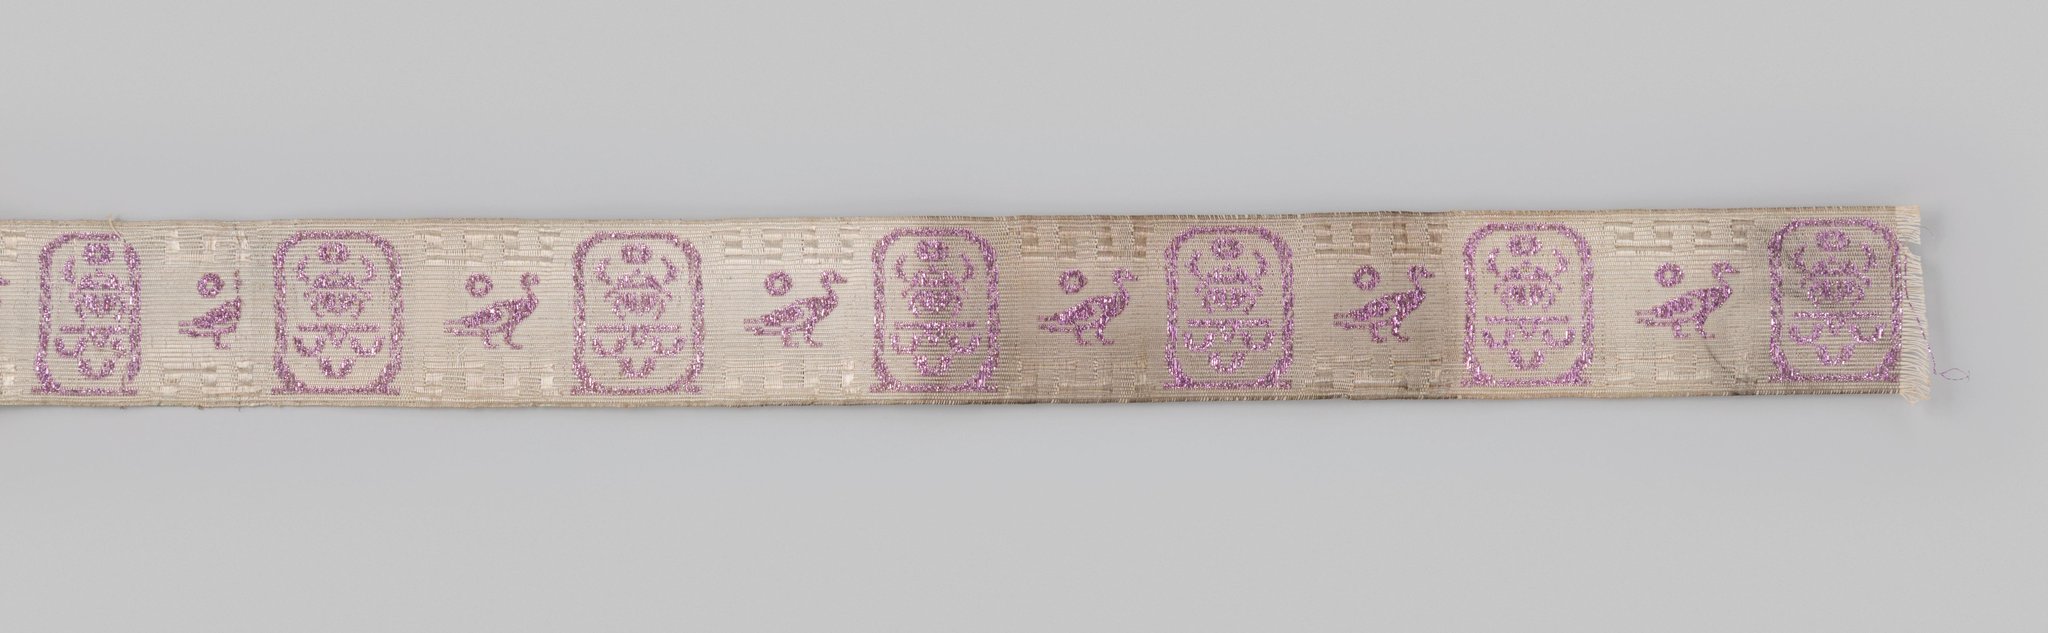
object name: ceintuurlint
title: Ceintuurlint van zilverbrokaat, versierd met paarse 'Egyptische' motieven van hieroglyphen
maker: Anonymous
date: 1920-1930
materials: silver brocade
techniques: brocade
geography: france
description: Ceintuurlint van zilverbrokaat, versierd met paarse 'Egyptische' motieven van hieroglyphen.